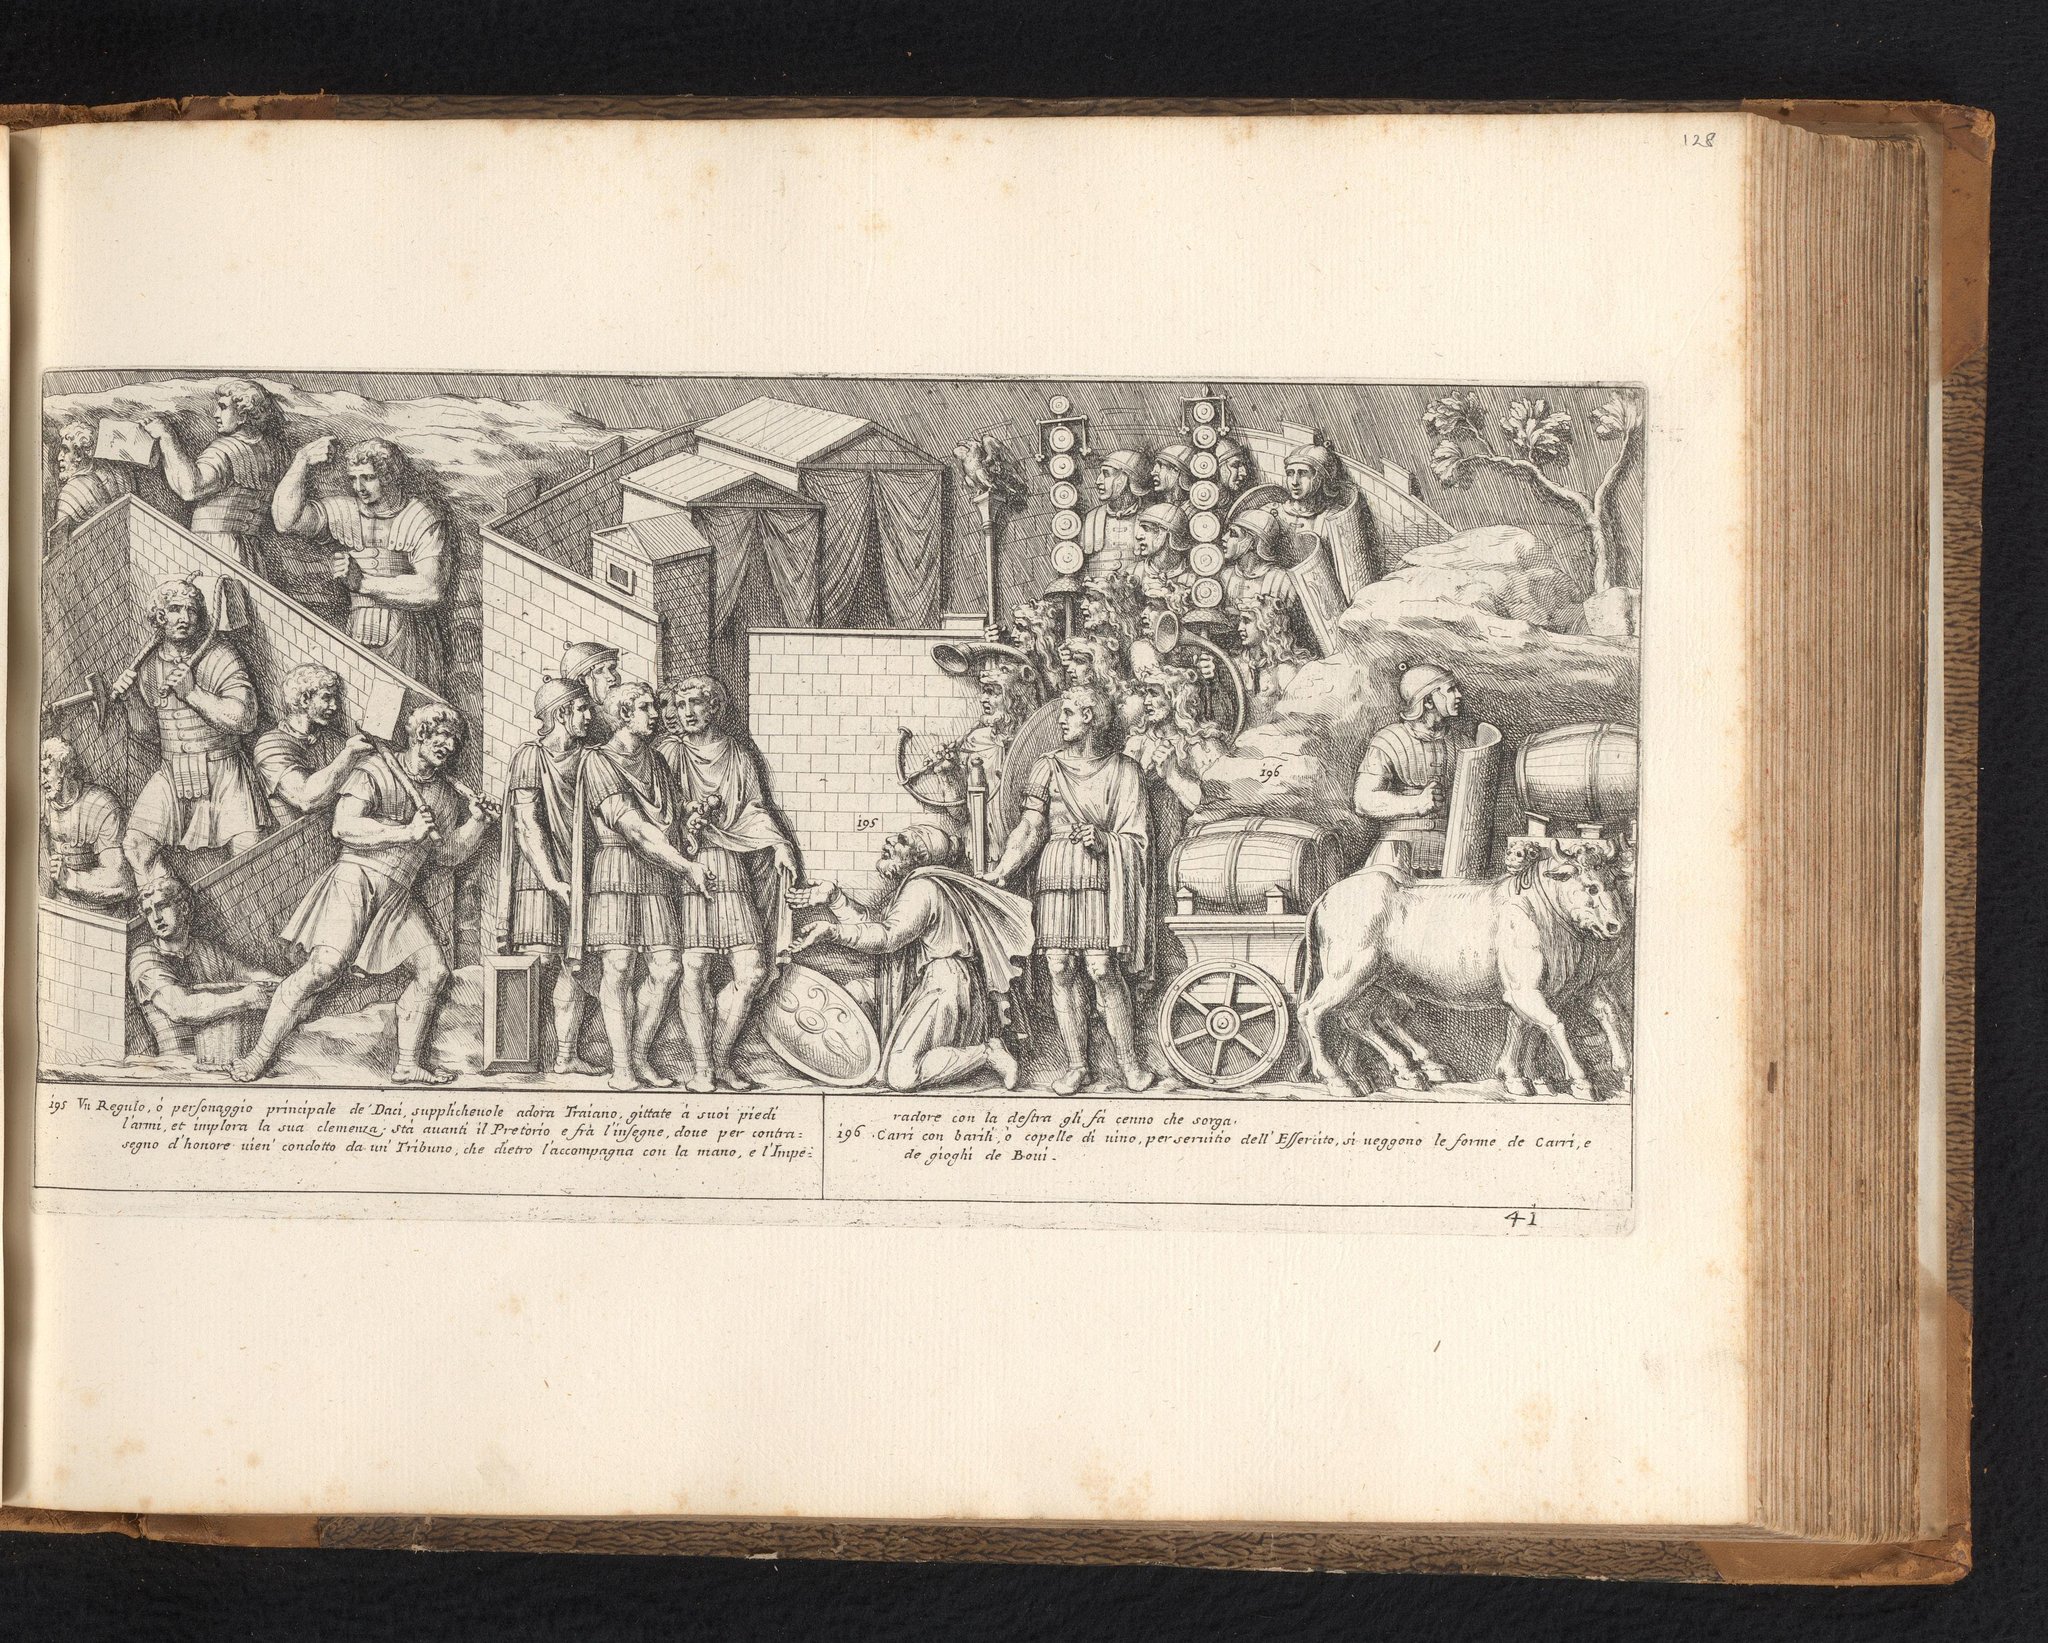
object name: album leaf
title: Zuil van Trajanus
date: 1637-1691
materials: paper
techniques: etching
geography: france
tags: triumphal column with helical friezes, piece of sculpture, reproduction of a piece of sculpture, the soldier; the soldier's life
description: Detail van het spiraalvormige gebeeldhouwde fries op de Zuil van Trajanus. Het fries toont de oorlogen tussen de Romeinen en de Daciërs. Verklarende nummers in de ondermarge. Prent maakt deel uit van een album.